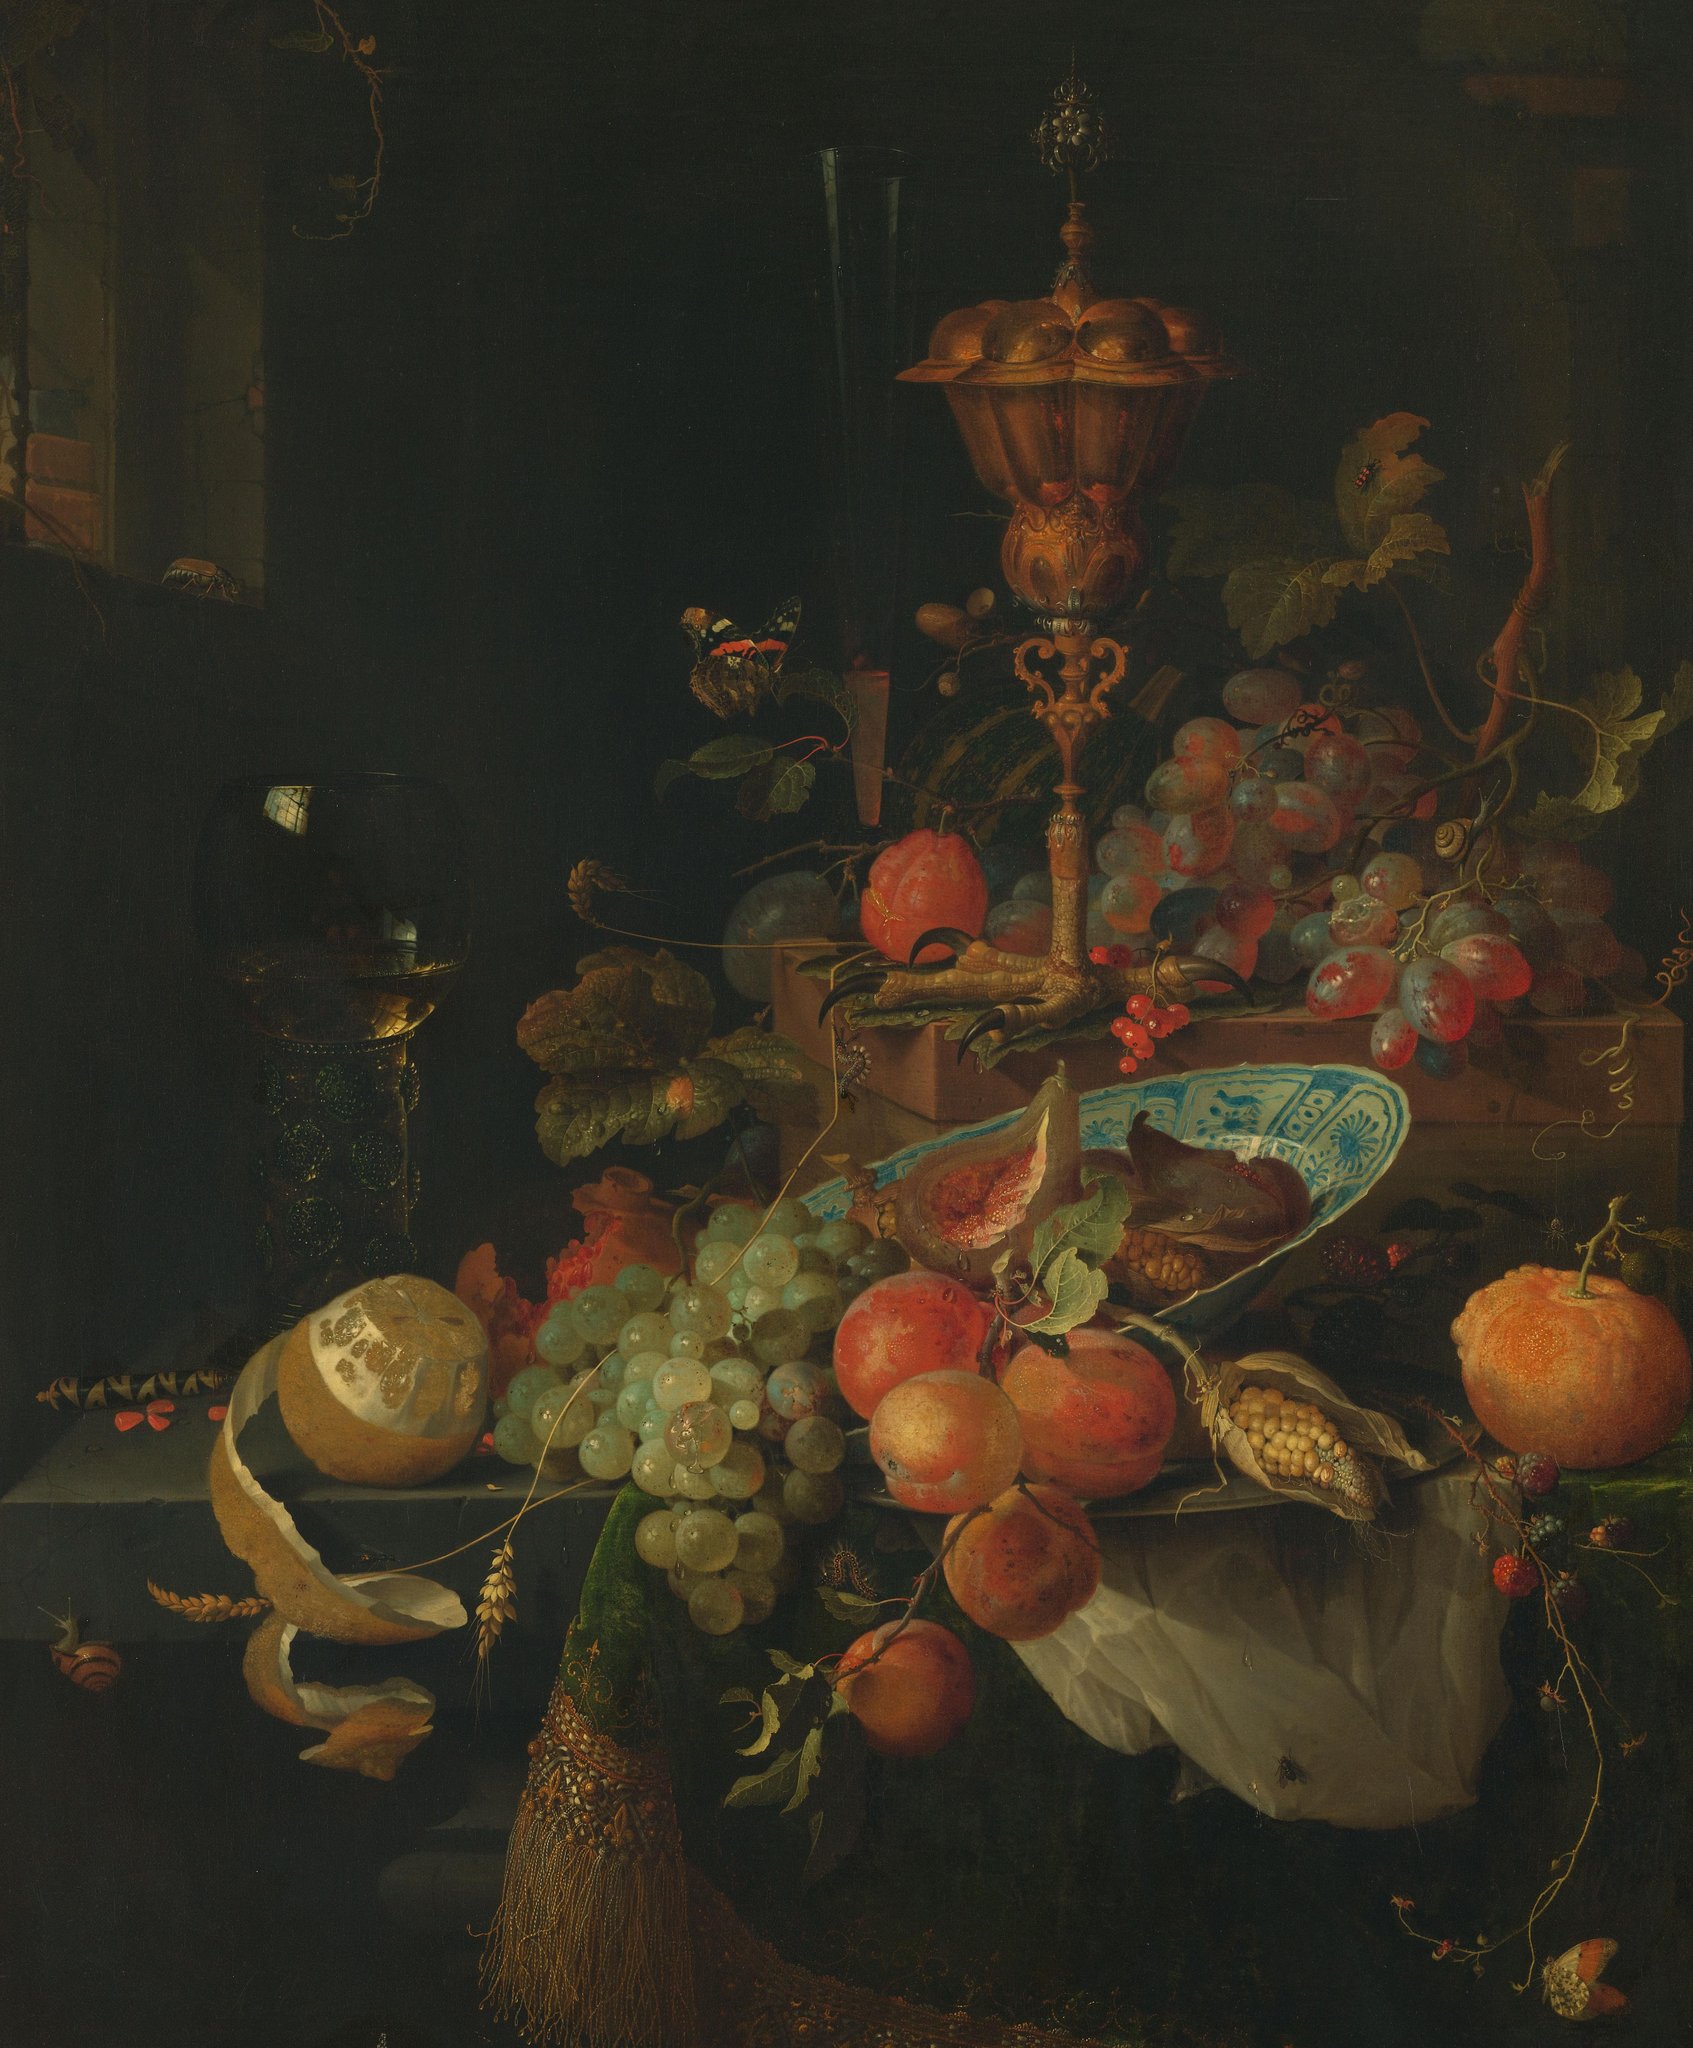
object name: painting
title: Still Life with Fruit and a Beaker on a Cock's Foot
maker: abraham mignon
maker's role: painter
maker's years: 1640-1679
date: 1660-1679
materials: canvas, oil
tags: fruit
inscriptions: signature: ‘A. Mignon fe.’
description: Stilleven met vruchten en een bokaal op hanenpoot. Op een Wan Li-schaal liggen druiven, granaatappels, perziken en maïs. Links een geschilde citroen en een roemer met wijn. Op de achtergrond een gouden bokaal op een hanenpoot, druiven en een kalebas op een houten doos. Tussen het fruit slakken en vlinders, links bij het raam een kever.